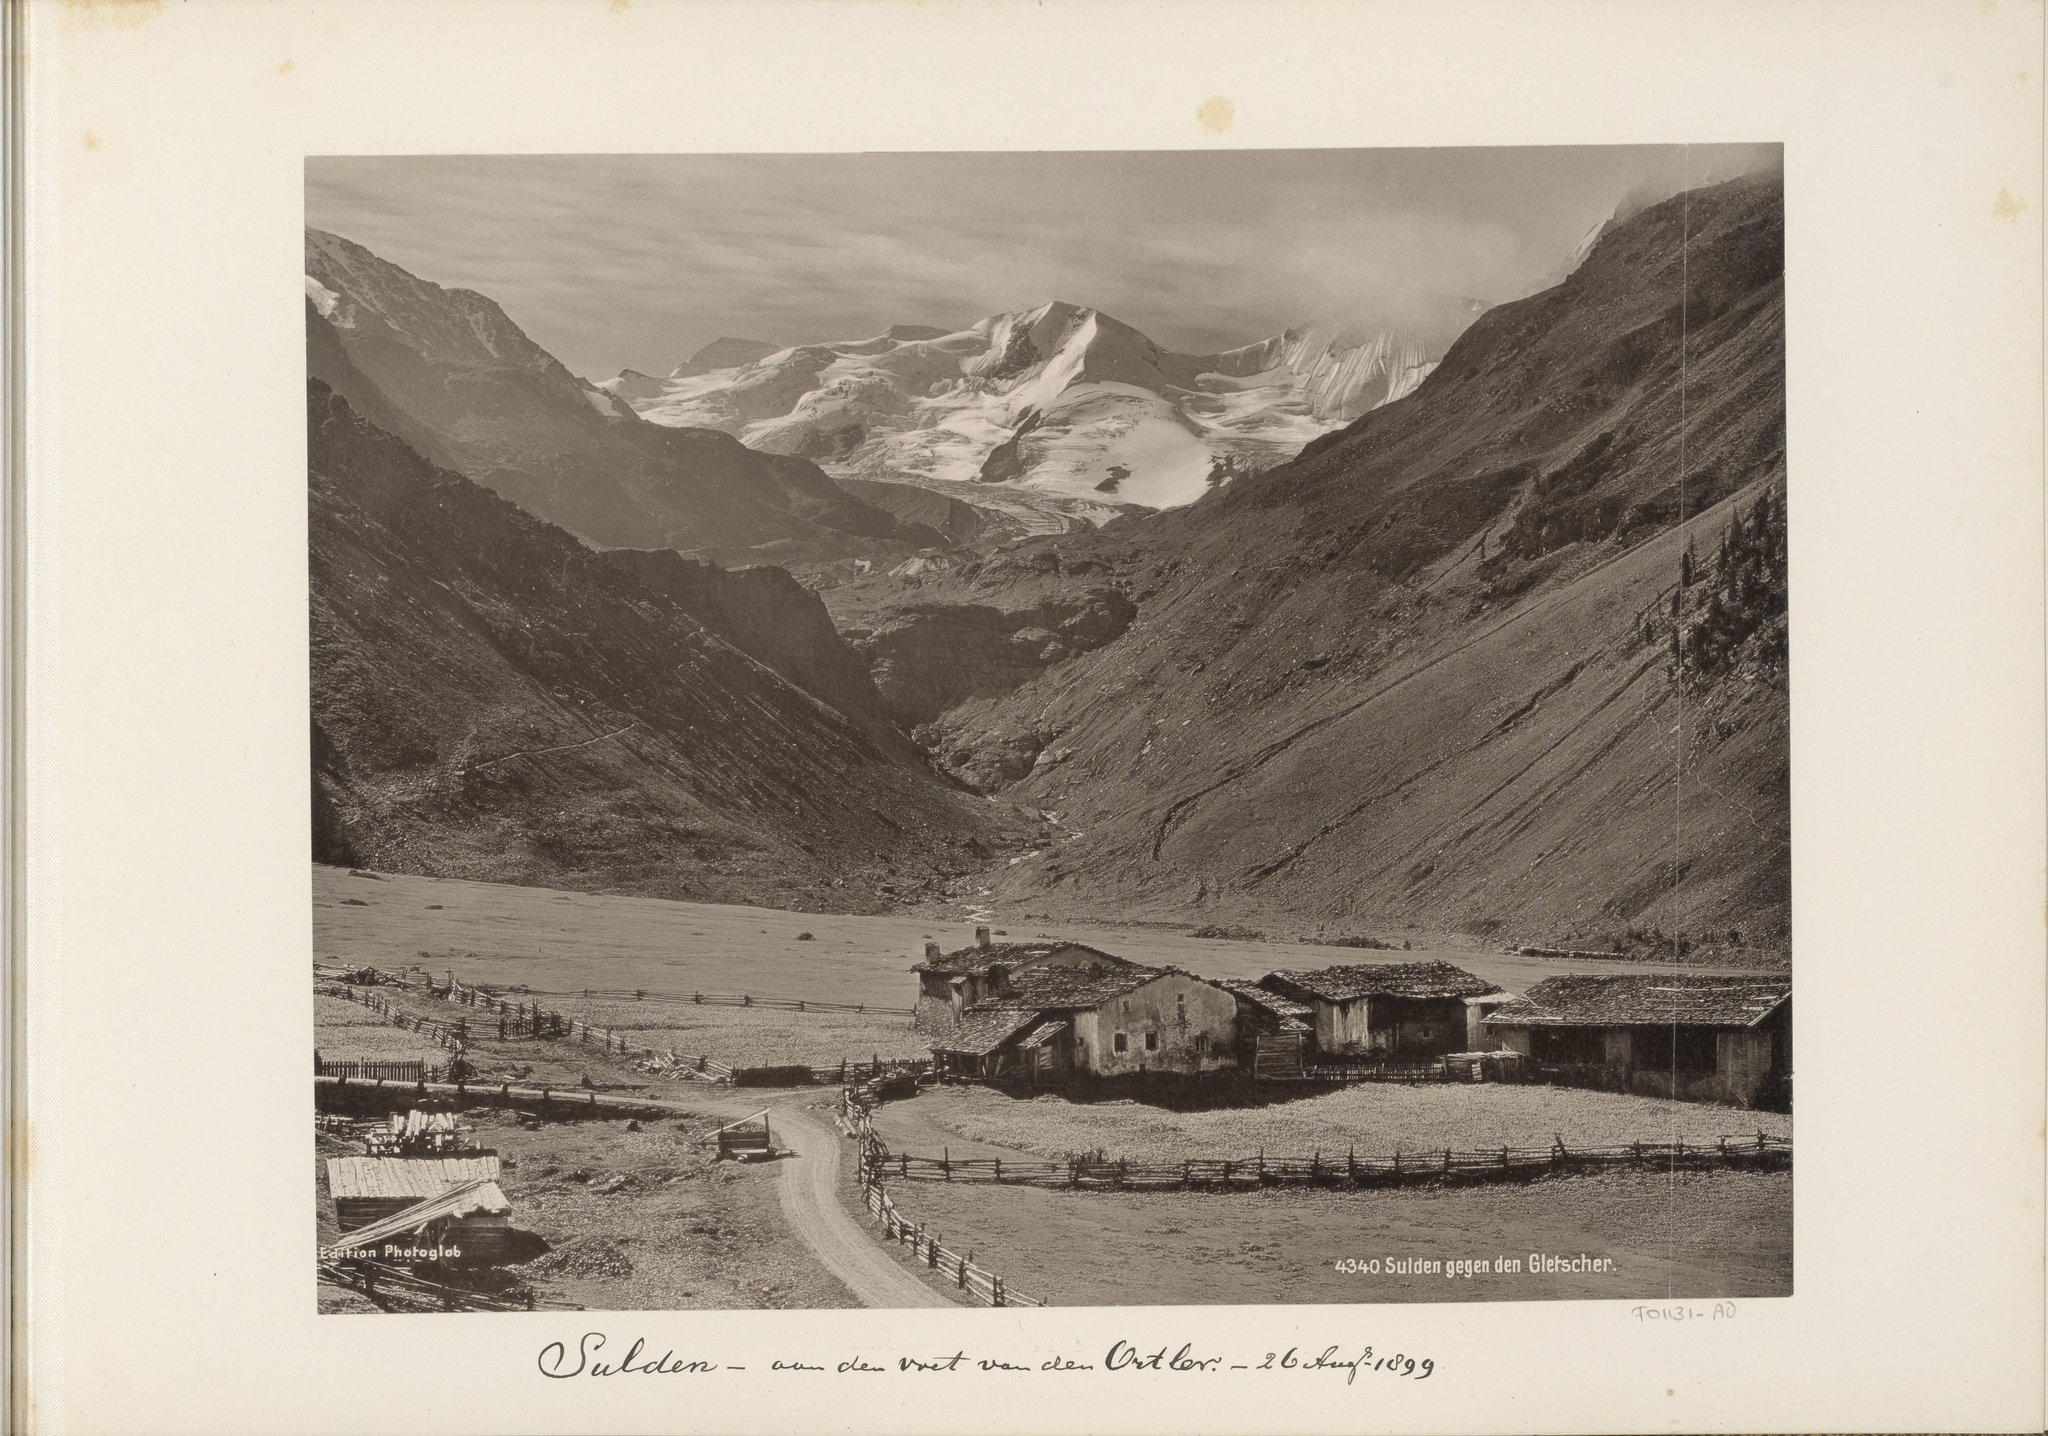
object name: photograph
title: Sulden gegen den Gletscher.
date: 1880-1899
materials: paper, ink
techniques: photograph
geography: sulden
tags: dale, valley, glacier, stall, stable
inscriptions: number: ‘4340’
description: Onderdeel van Reisalbum met bezienswaardigheden in Duitsland, Oostenrijk, Zwitserland, Luxemburg en België.